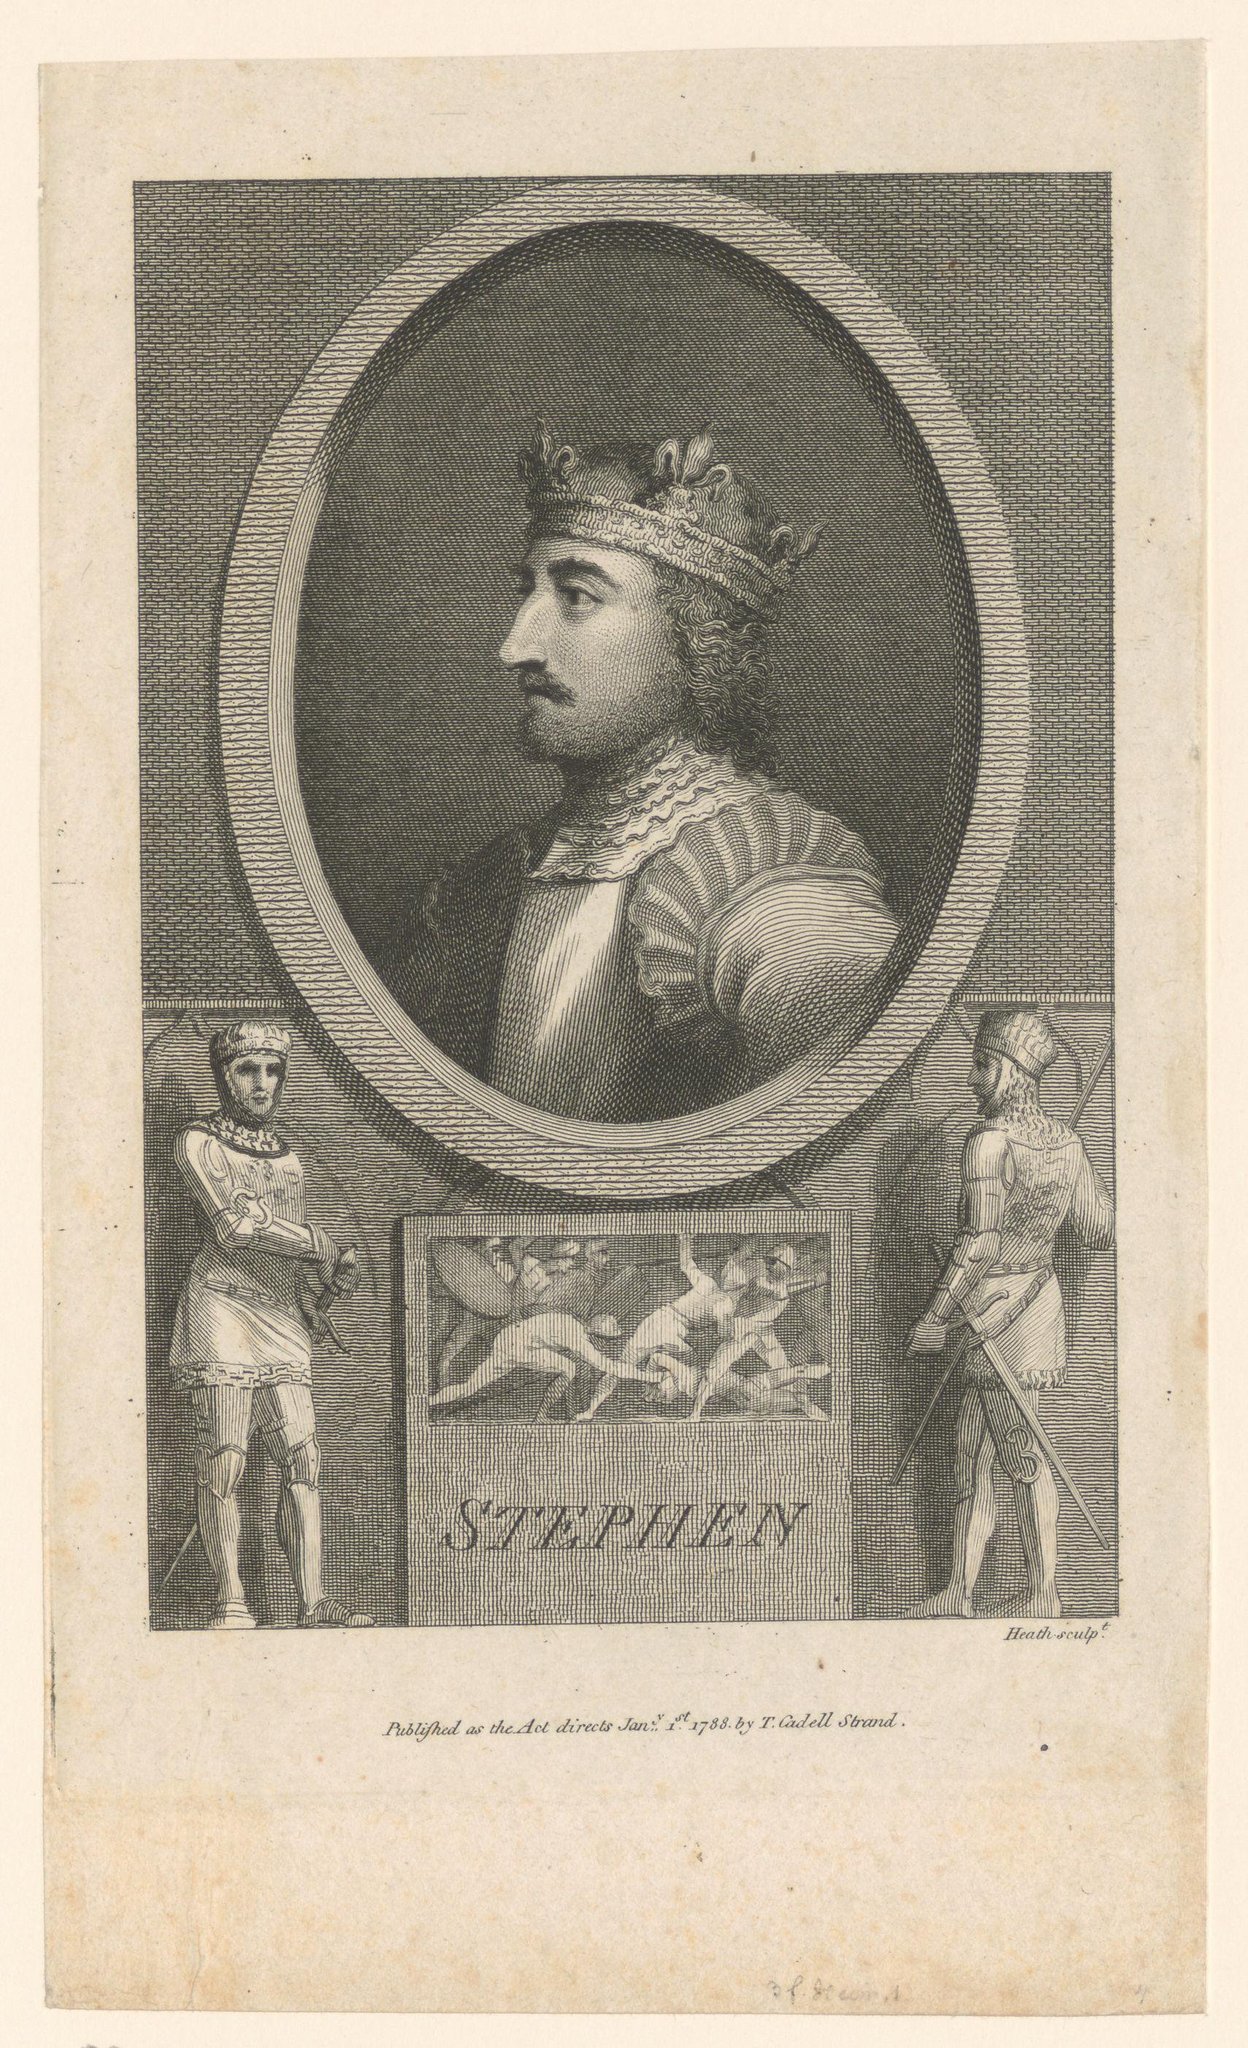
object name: book illustration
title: Portret van Stefanus van Engeland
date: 1701-1788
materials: paper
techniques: engraving, etching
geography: london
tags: historical persons, king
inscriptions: collector's mark: Lugt 2228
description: Prent uit: Hume, David. History of England (...). Londen: Thomas Cadell, 1789, dl. 1, p. 348.